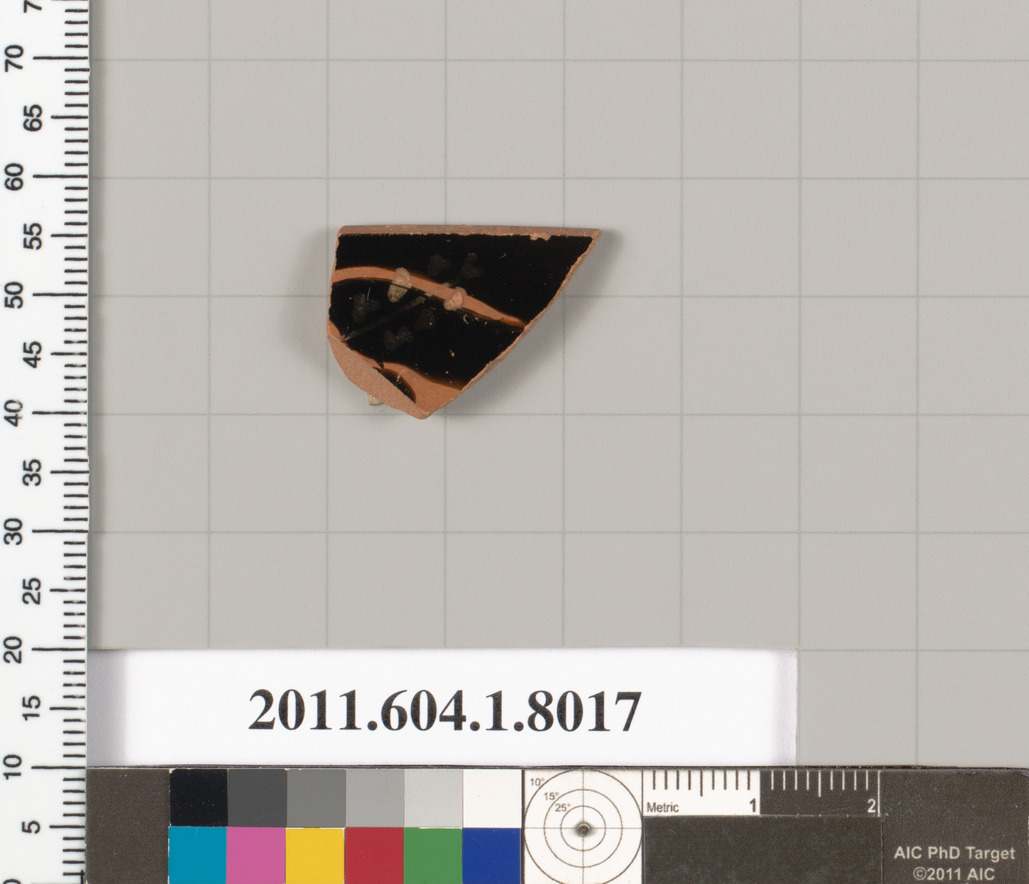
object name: kylix fragment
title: Terracotta rim fragment of a kylix (drinking cup)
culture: greek, attic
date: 510-500 BCE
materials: terracotta